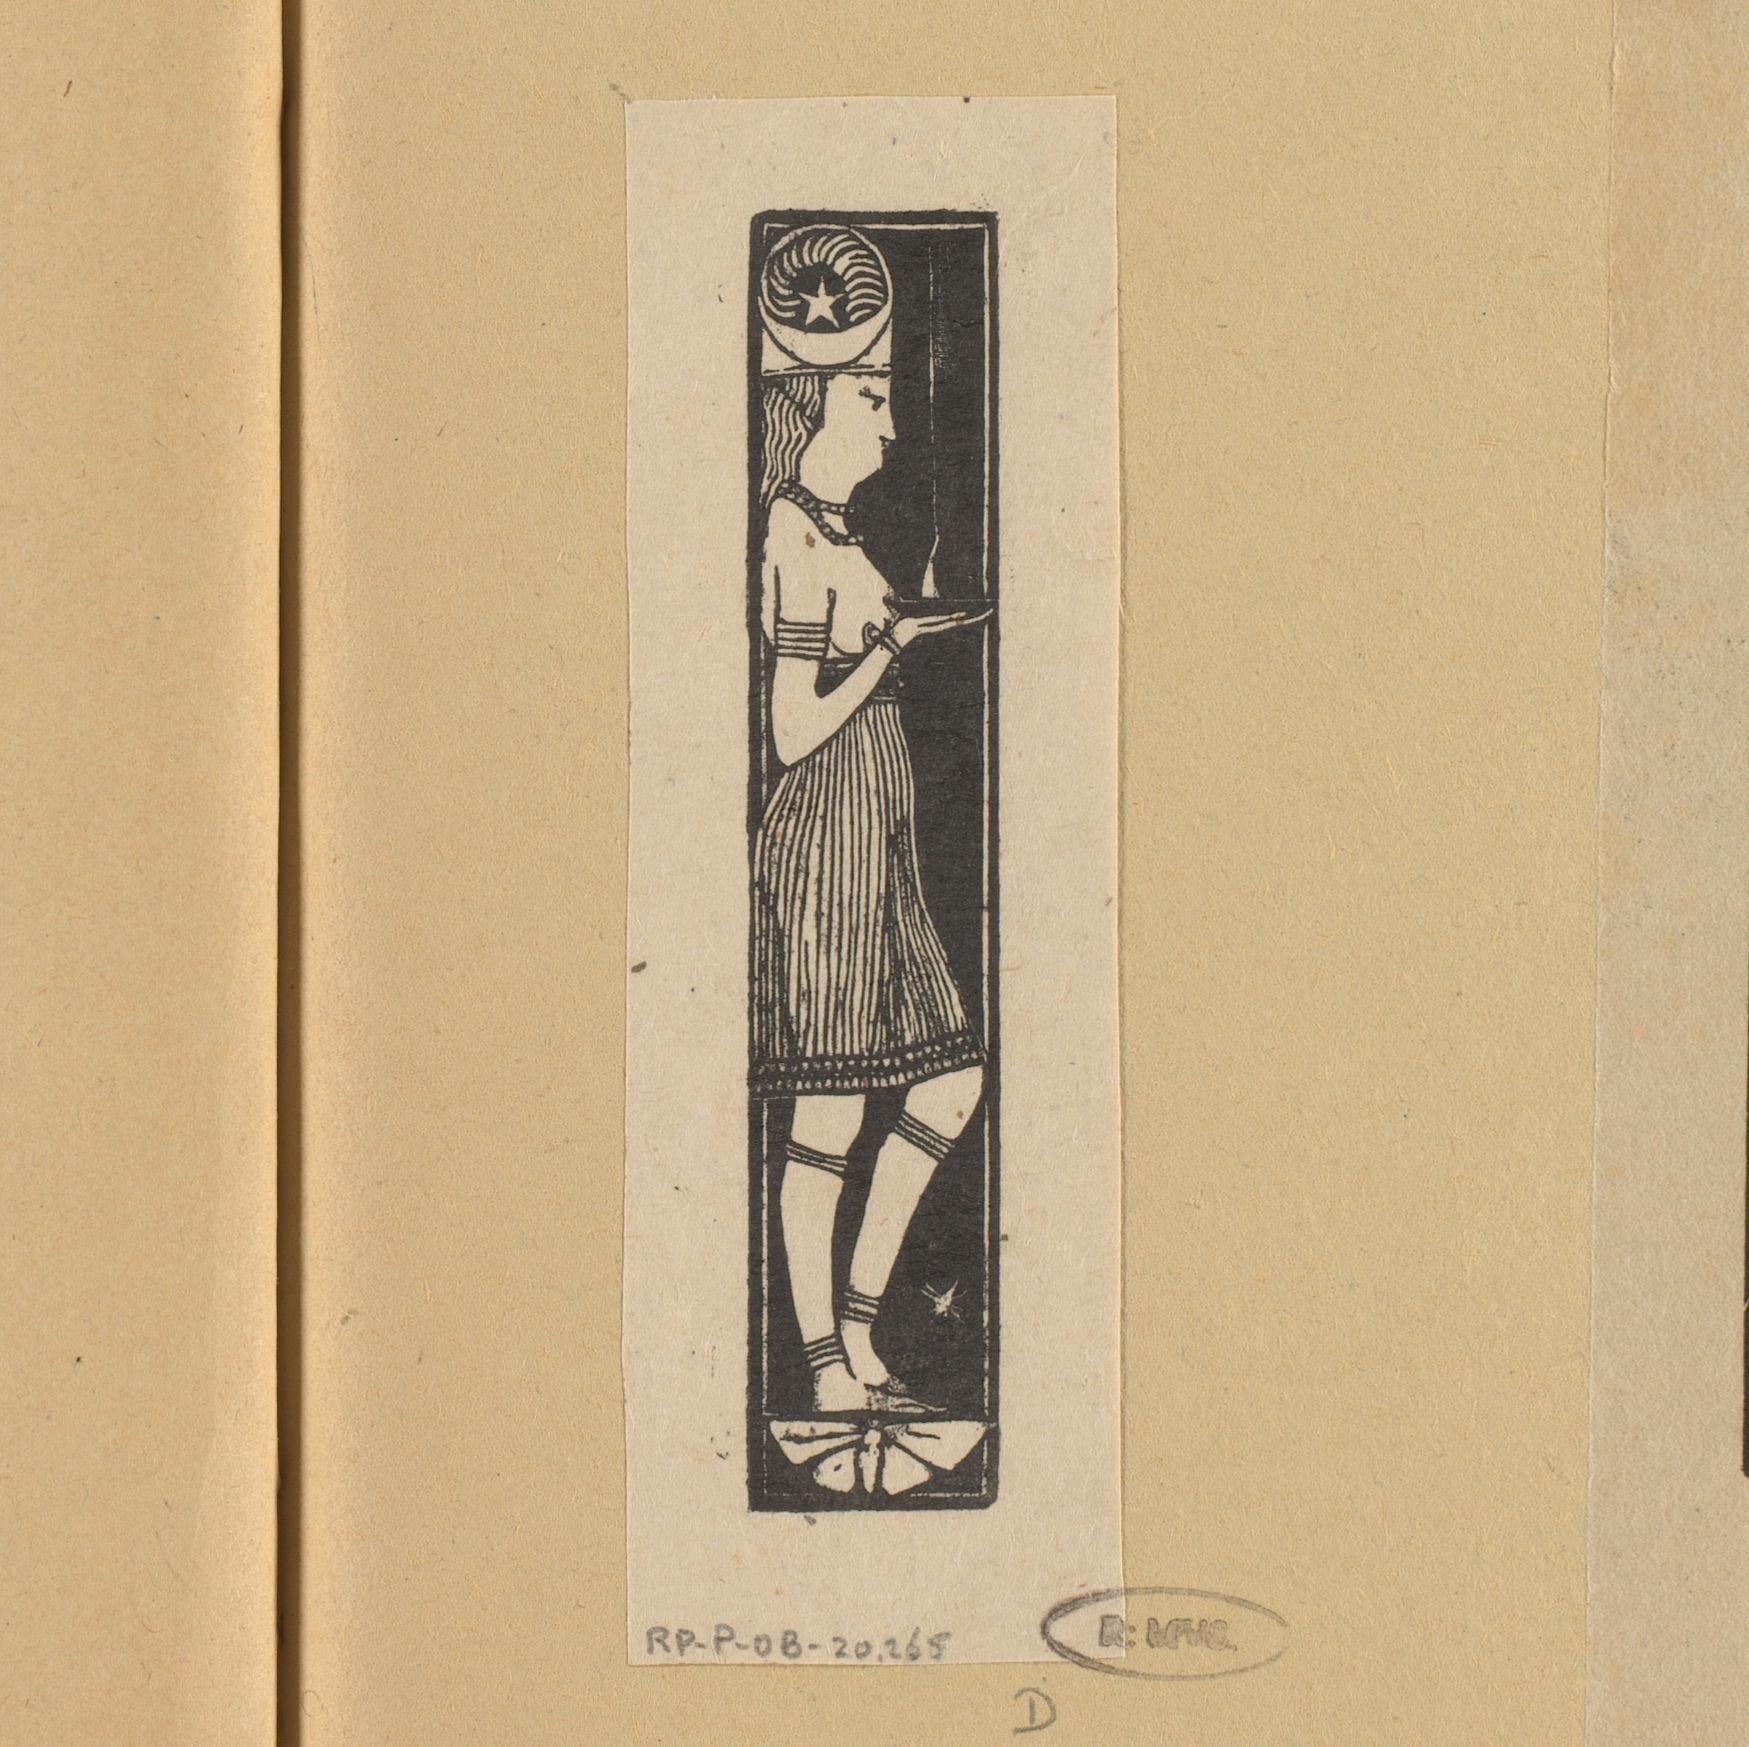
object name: print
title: Kama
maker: mathieu lauweriks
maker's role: designer, draughtsman, print maker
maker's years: 1864-1932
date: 1895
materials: paper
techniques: woodcut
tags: oil-lamp, standing figure - aa - female human figure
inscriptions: collector's mark: Lugt 2228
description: De vrouw staat boven een vlinder. Ze draagt een jurk en een hoed met een ster. Haar borsten zijn ontbloot. Deze prent maakt deel uit van een album.